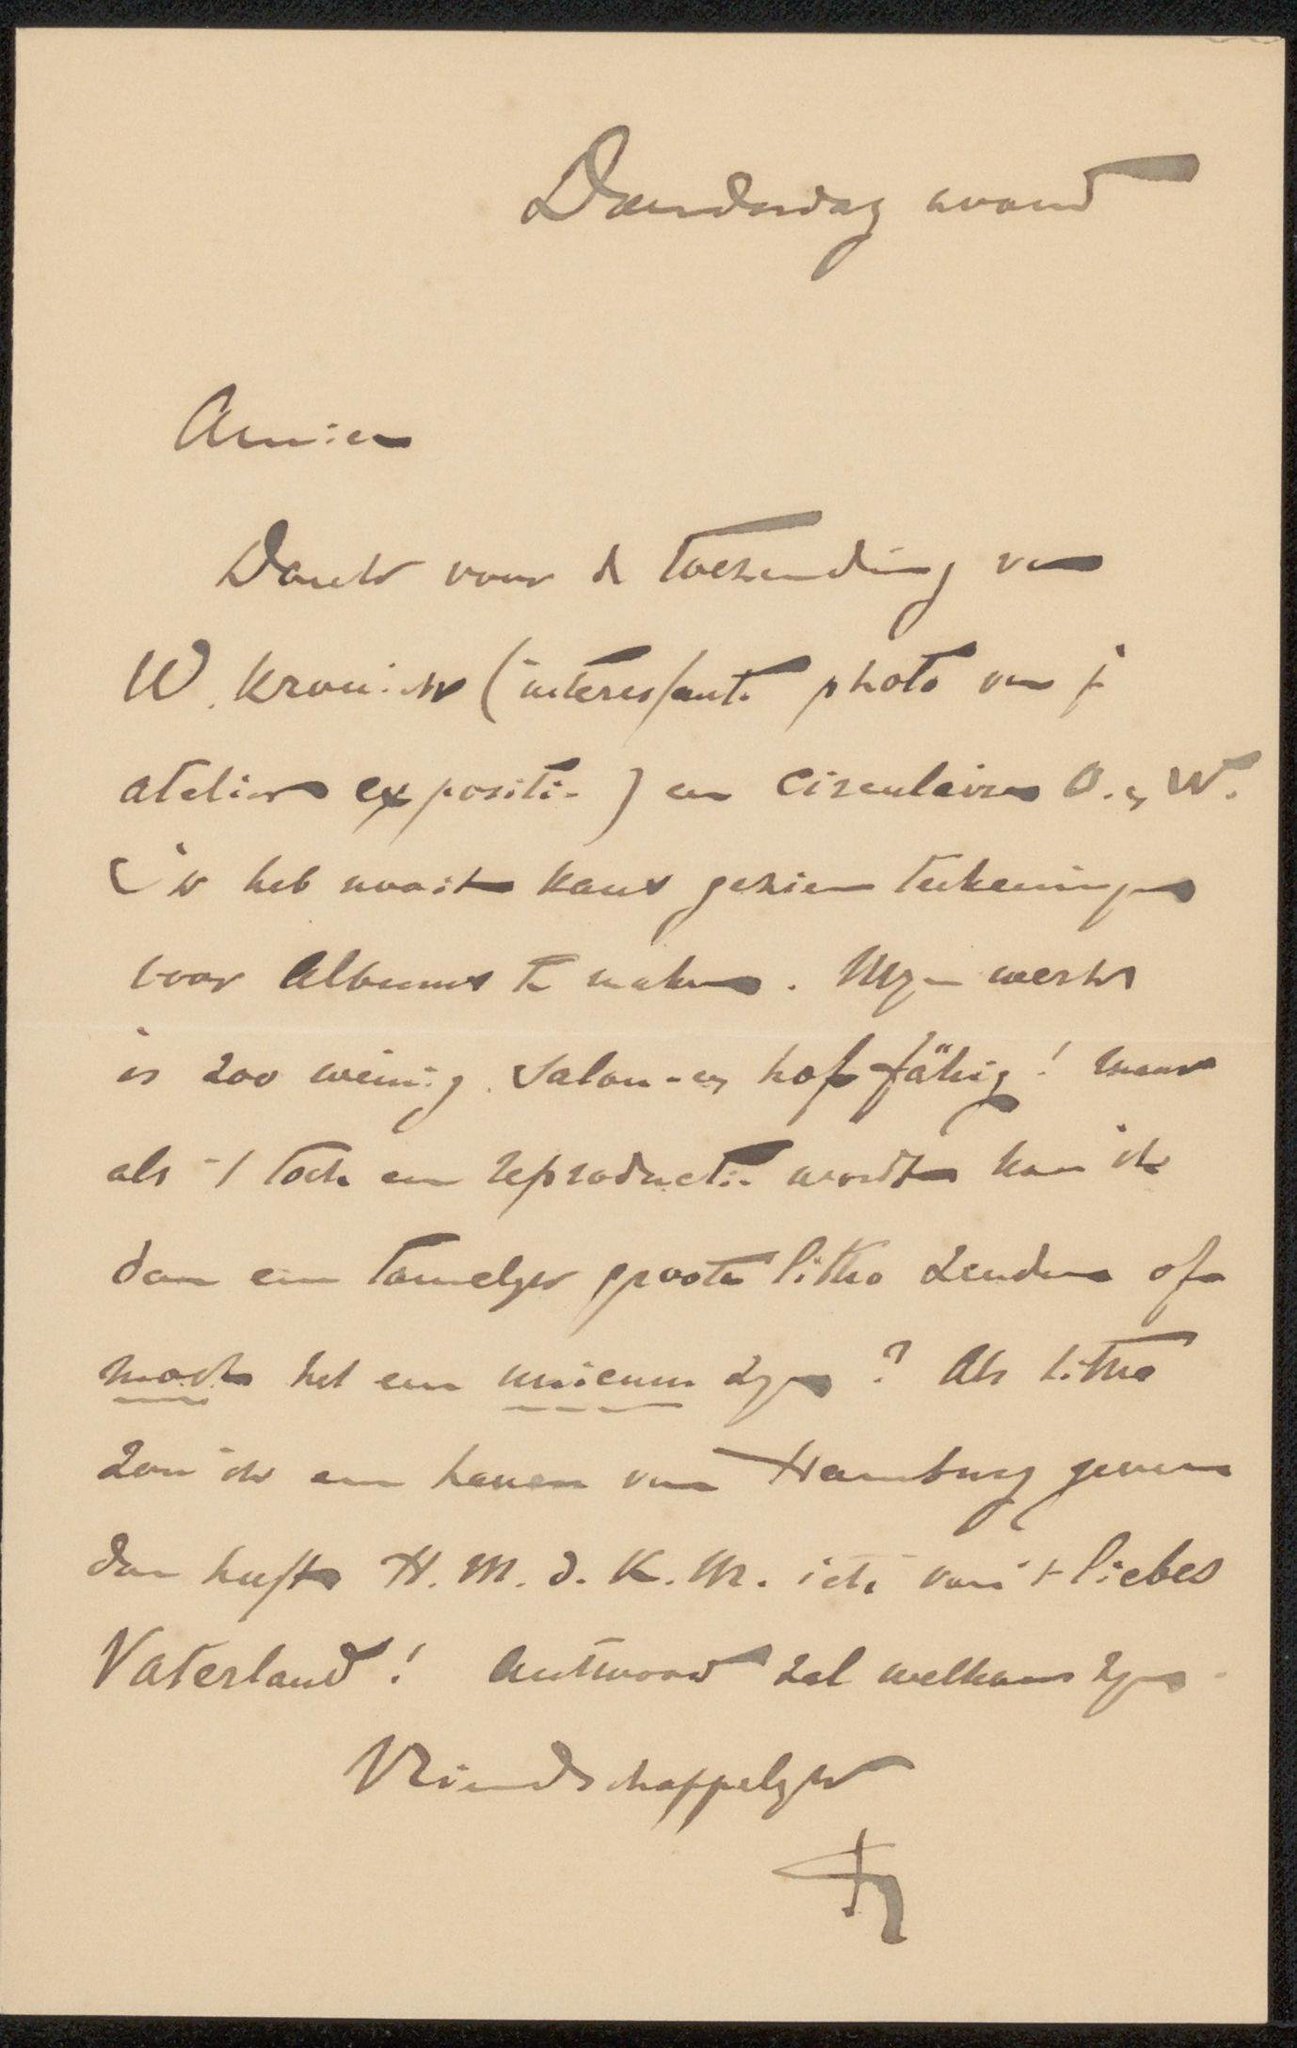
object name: letter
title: Brief aan Philip Zilcken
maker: carel nicolaas storm van s-gravesande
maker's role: draughtsman, print maker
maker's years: 1841-1924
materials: ink, paper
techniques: pen, writing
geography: the hague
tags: painter, philip zilcken, drawing, exhibition ~ art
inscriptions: watermark, collector's mark: ‘RPK’